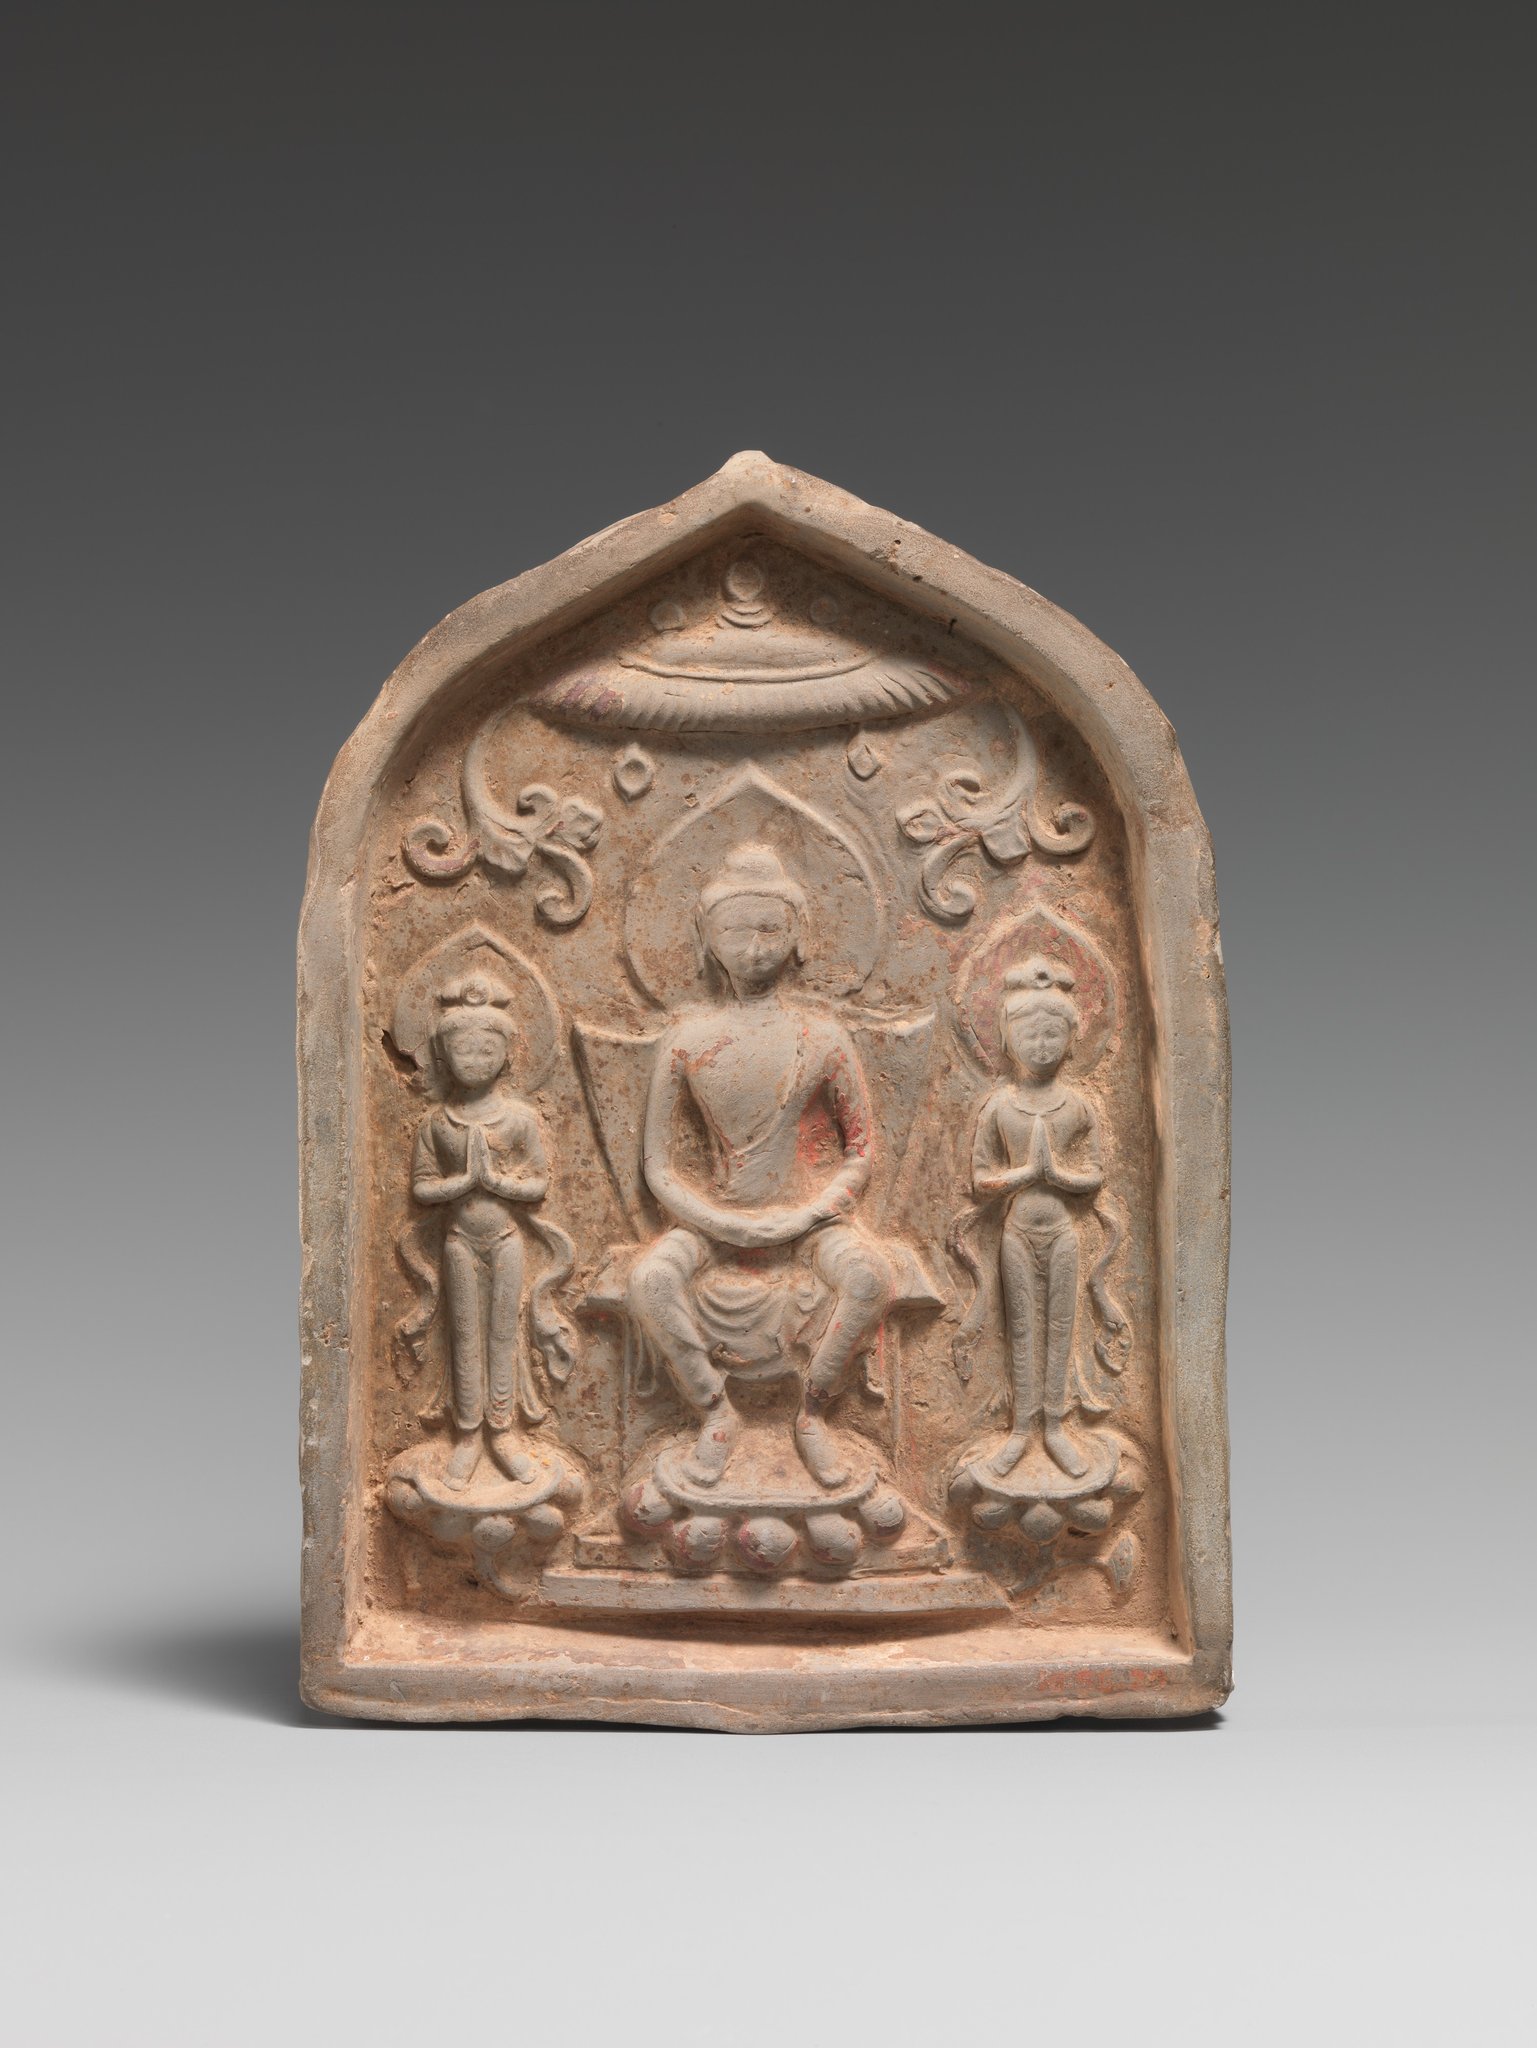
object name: votive tablet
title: Votive Tablet with Buddhist Triad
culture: chinese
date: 601-700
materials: earthenware, pigment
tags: buddha